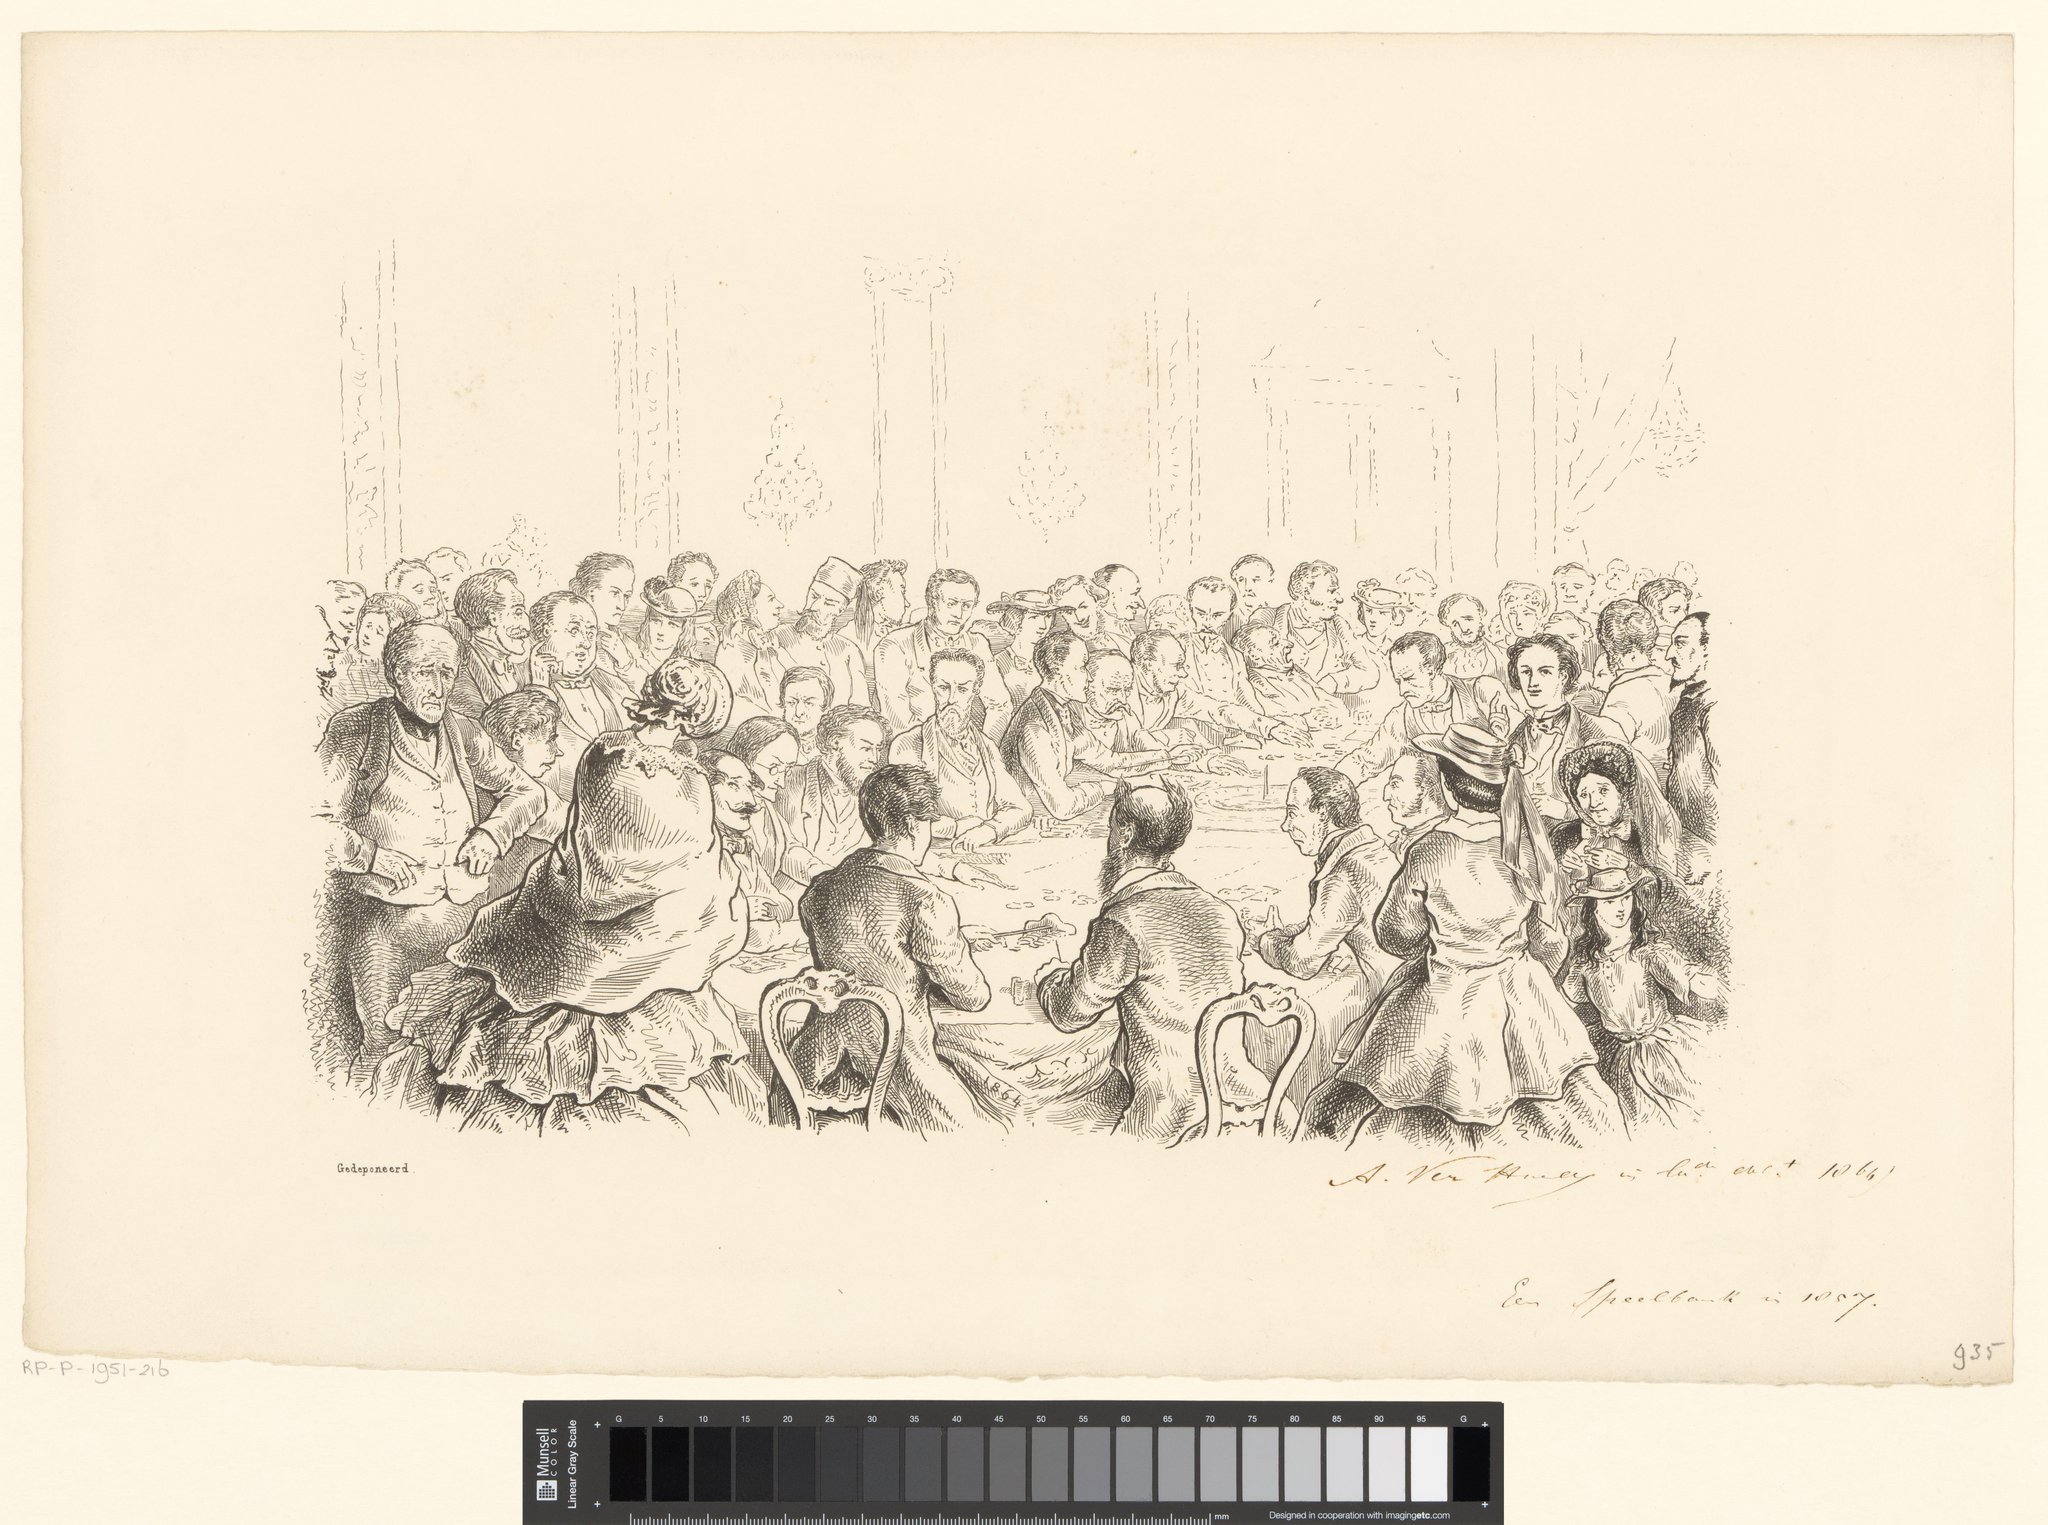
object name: print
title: Uit het verleden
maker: alexander ver huell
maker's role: draughtsman, print maker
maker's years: 1822-1897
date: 1864-1866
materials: paper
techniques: lithograph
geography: arnhem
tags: casino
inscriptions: : ‘Gedeponeerd.’, collector's mark: Lugt 2228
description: Een groep mannen zit rondom een speeltafel met in het midden een roulette. Omstanders kijken toe.